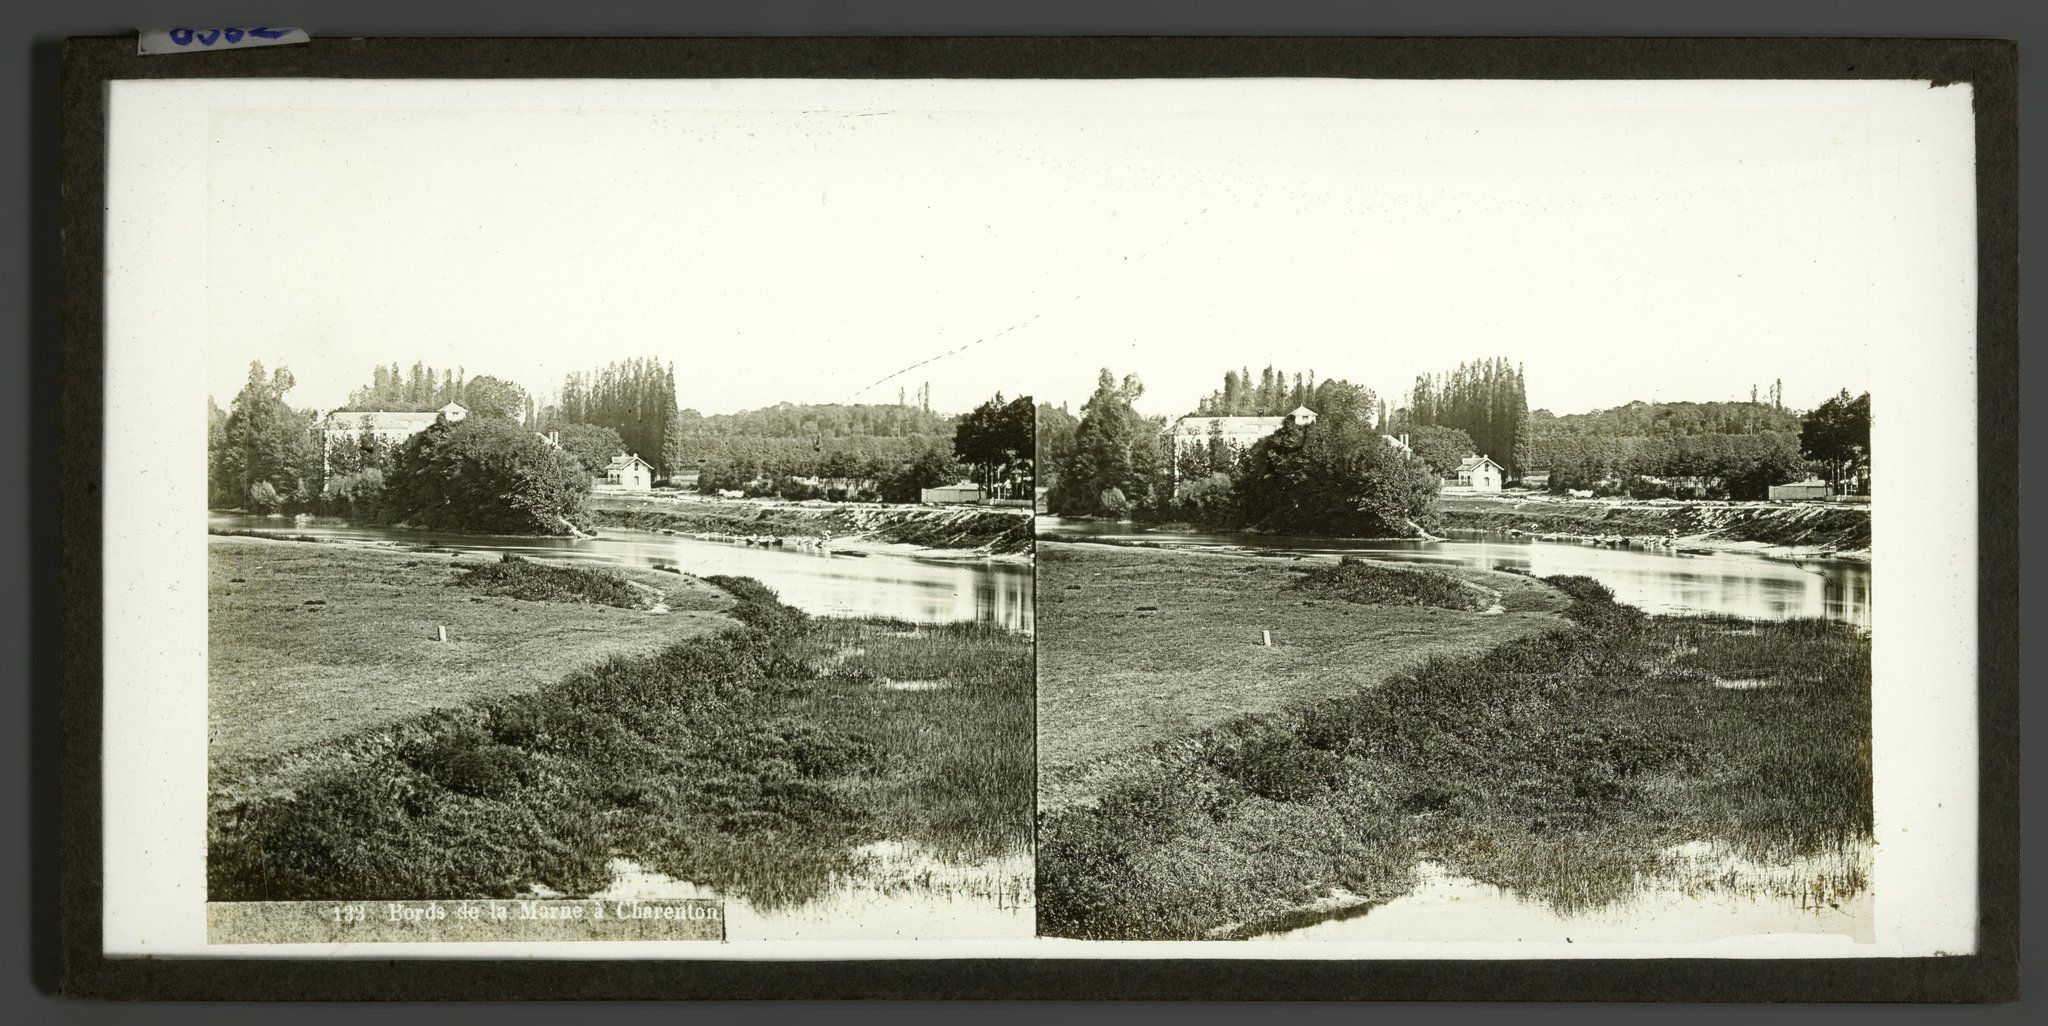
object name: stereoscopic photograph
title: Gezicht op de oever van de Marne in Charenton-le-Pont, Frankrijk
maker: Anonymous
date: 1856-1890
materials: glass, paper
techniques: slide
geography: charenton-le-pont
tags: river bank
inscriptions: number: ‘133’